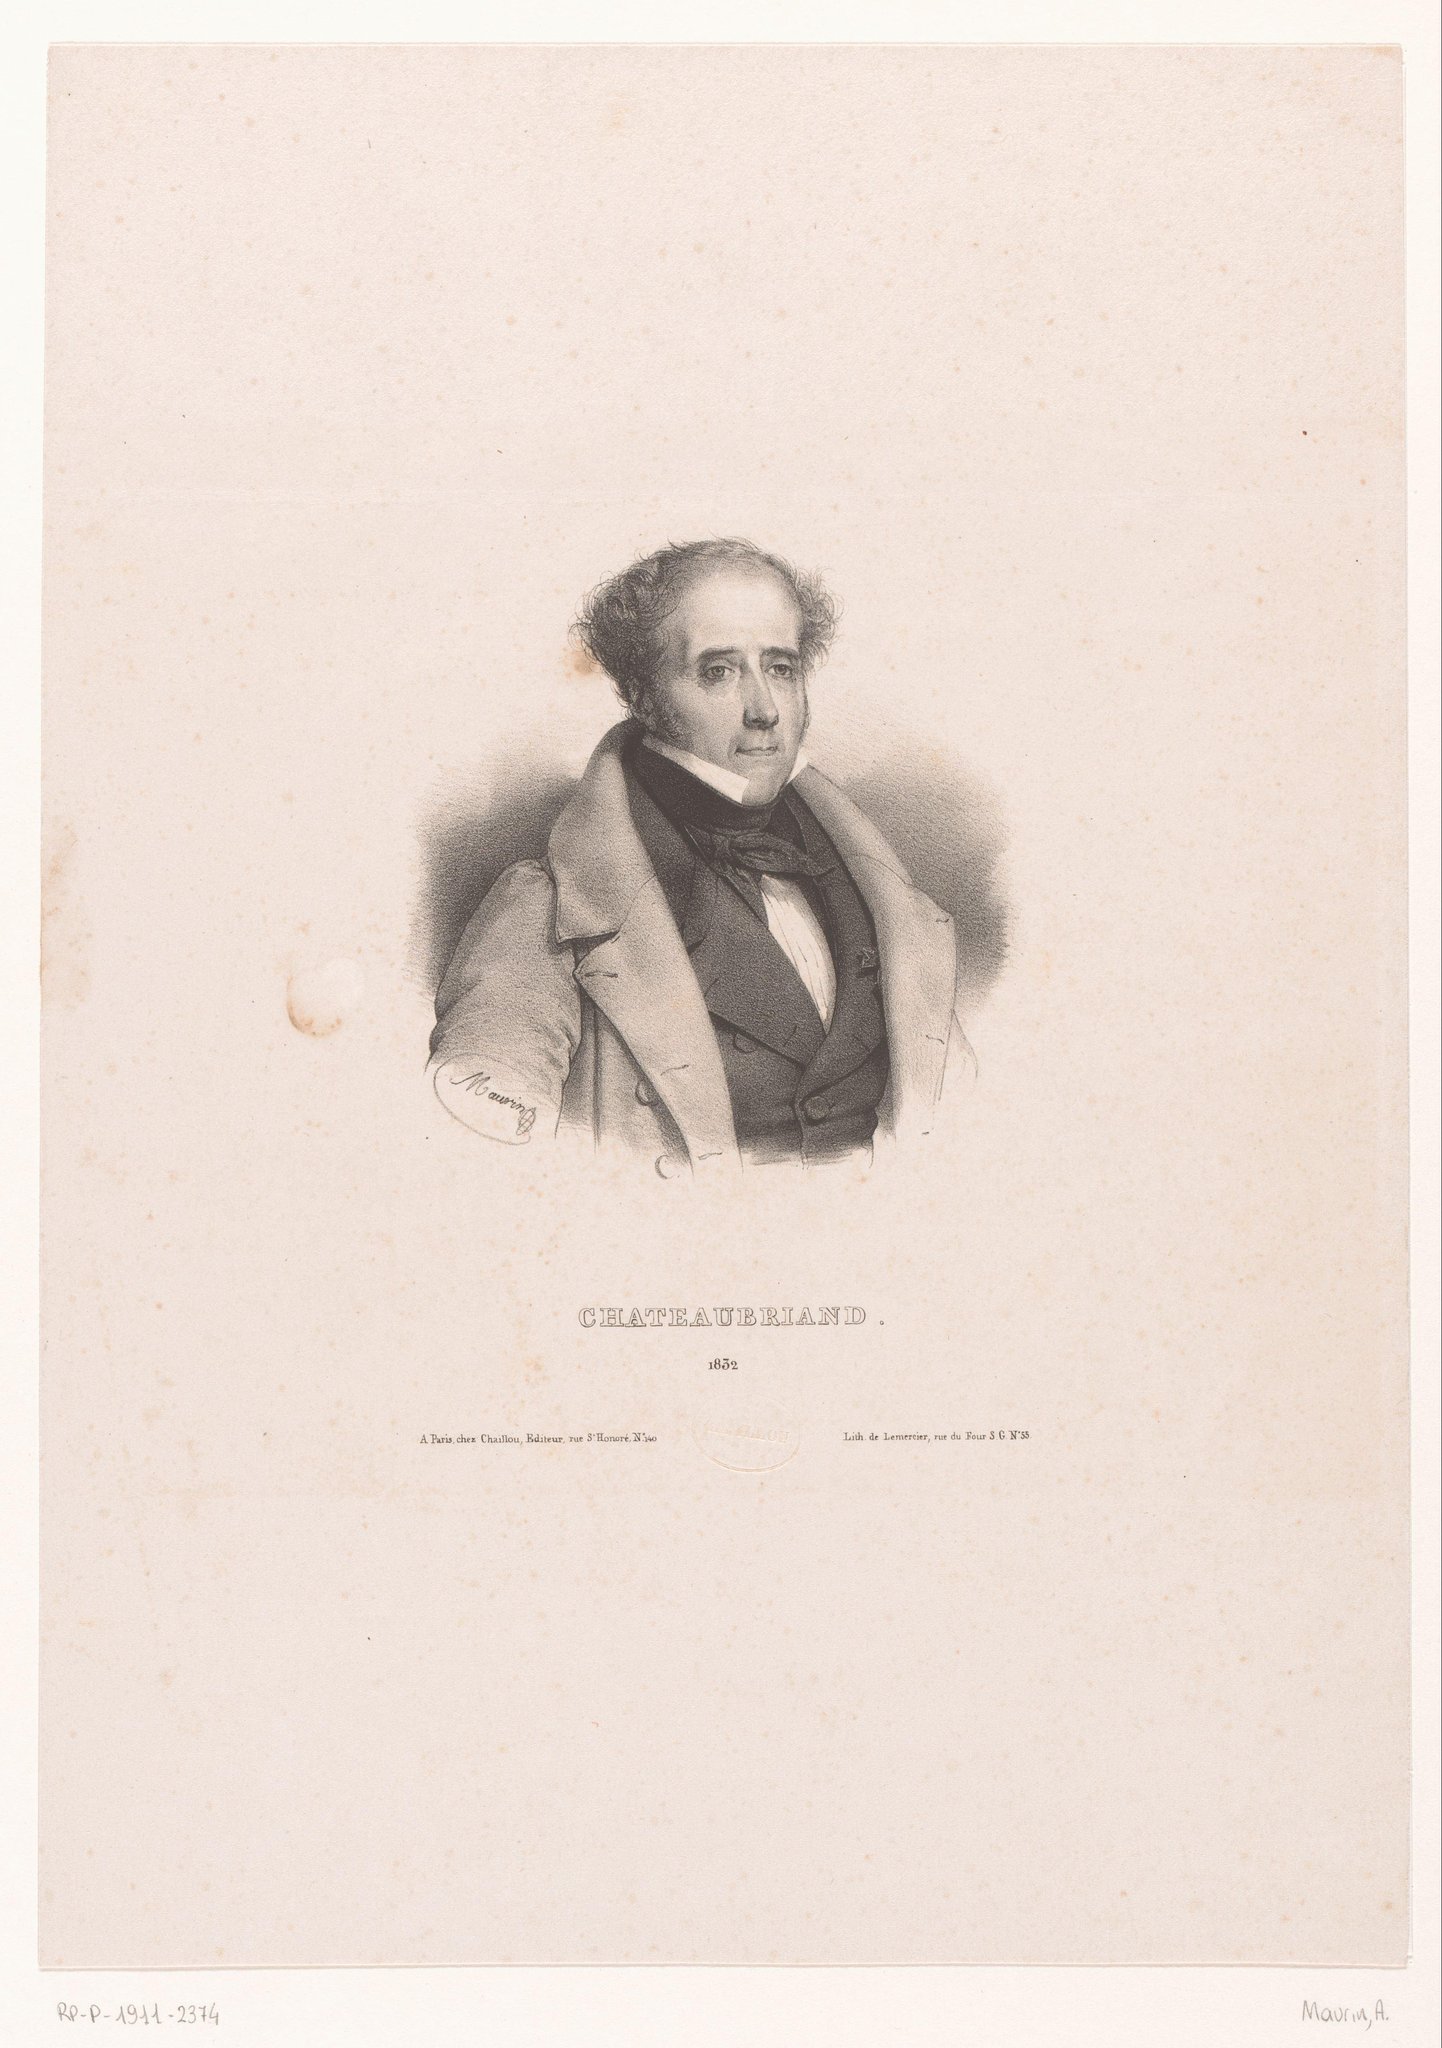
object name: print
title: Portret van François-René de Chateaubriand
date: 1832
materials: paper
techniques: lithograph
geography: paris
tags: paris, politician, françois-rené de chateaubriand, historical persons, politician, e.g. party leader, writer, poet, author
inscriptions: check stamp: Lugt 4733, collector's mark: Lugt 2228